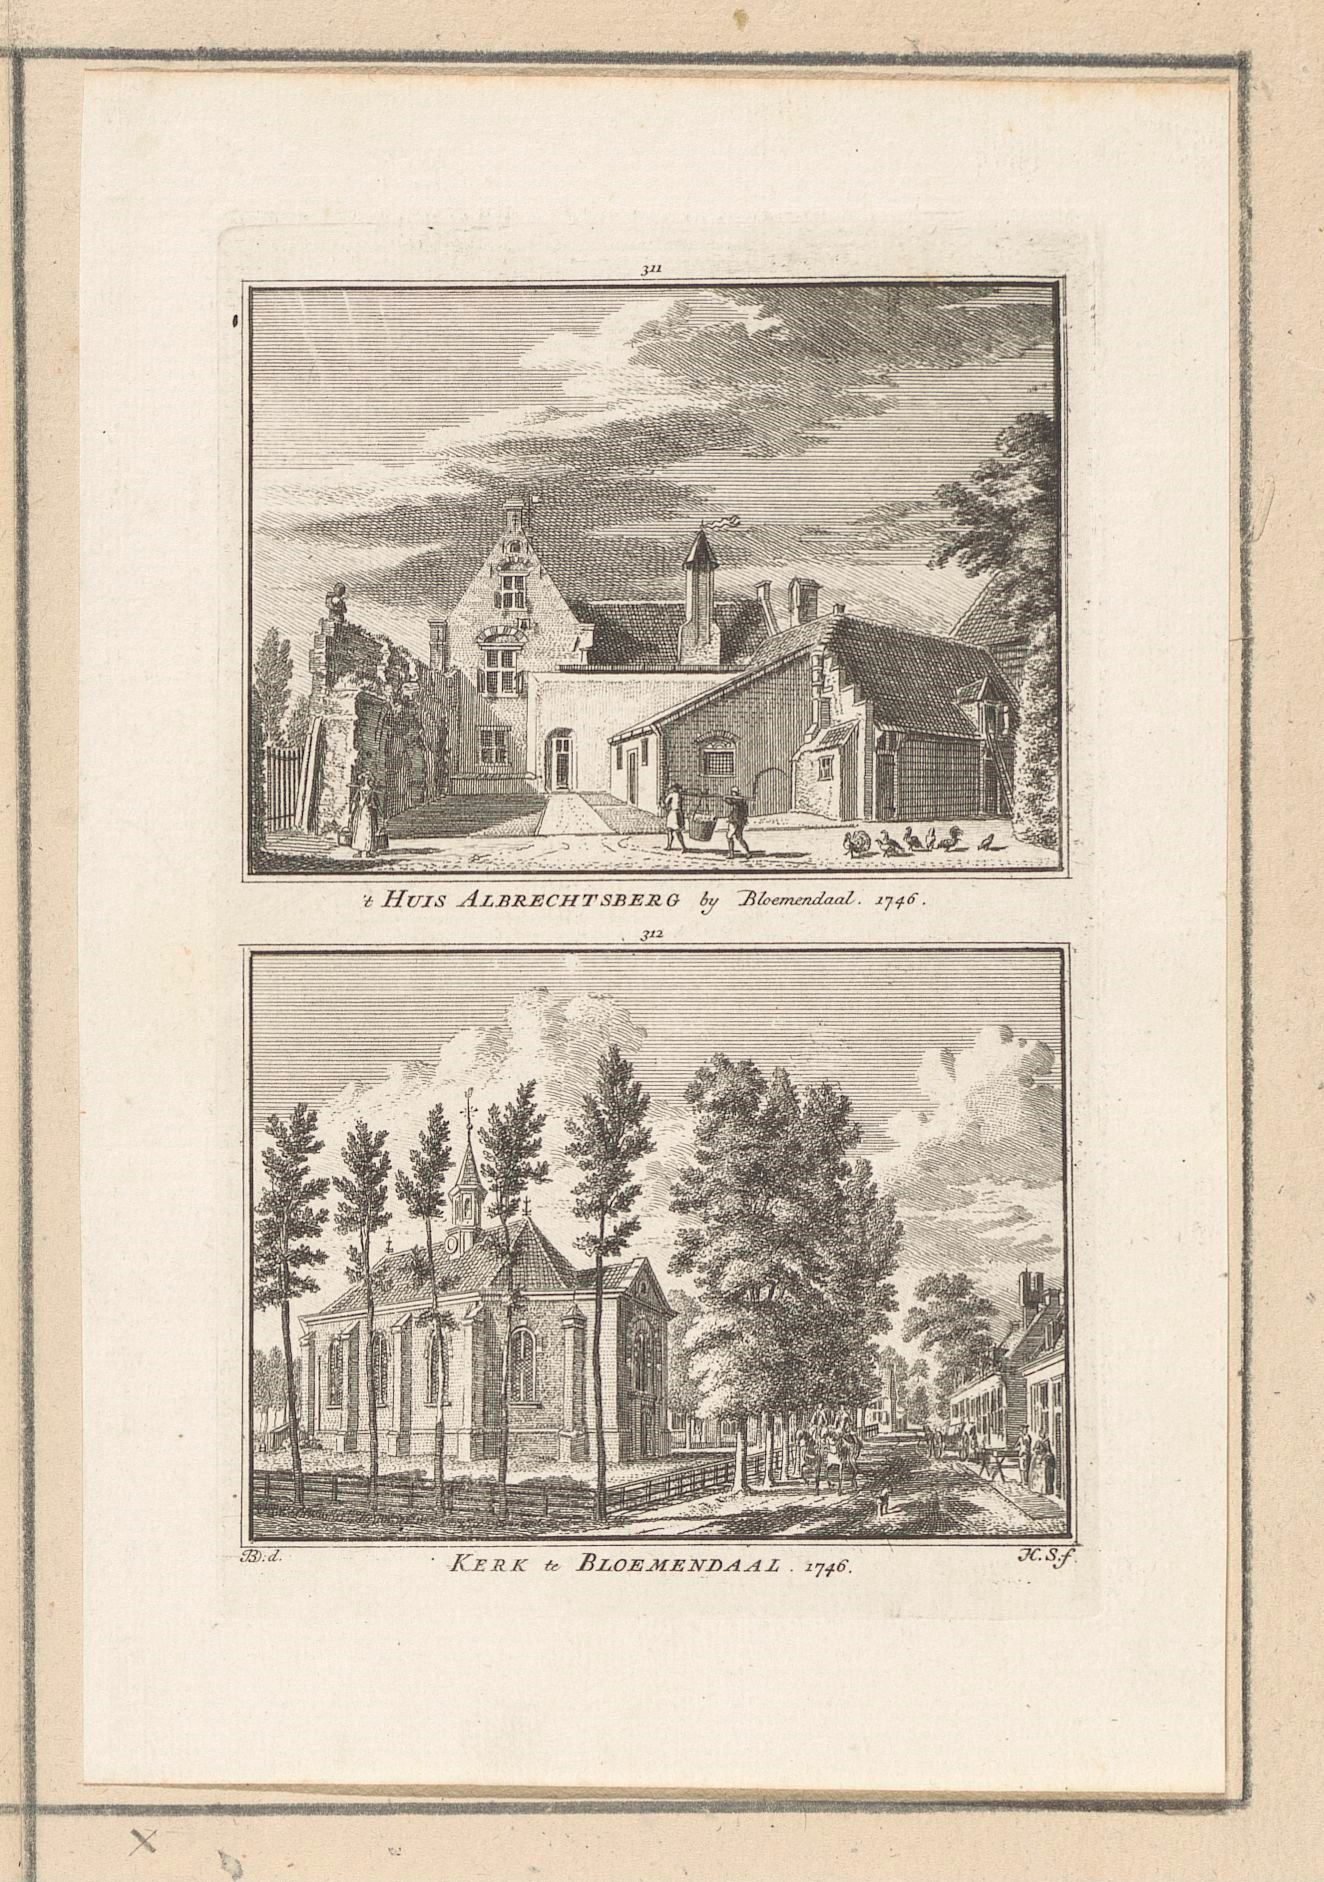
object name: print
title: Gezicht op Huis Aalbertsberg en gezicht op de kerk te Bloemendaal, 1746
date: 1752-1792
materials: paper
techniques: engraving, etching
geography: haarlem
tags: castle, church (exterior)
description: Prent ook gebruikt in: Het verheerlykt Nederland of kabinet van hedendaagsche gezigten van steden, dorpen (…). 9 delen. Amsterdam: Isaak Tirion en weduwe Isaak Tirion, 1745-1774, dl. 4 (1752), ill. 311 en 312. Of in: Nederlandsche tafereelen; of eene keurige verzameling van negen honderd fraaije gezigten van steden, dorpen, sloten, oudheden (….). 9 delen. Amsterdam: Jan de Groot, 1792, dl. 4, ill. 311 en 312. Uit welke druk het huidige exemplaar precies komt is niet na te gaan.